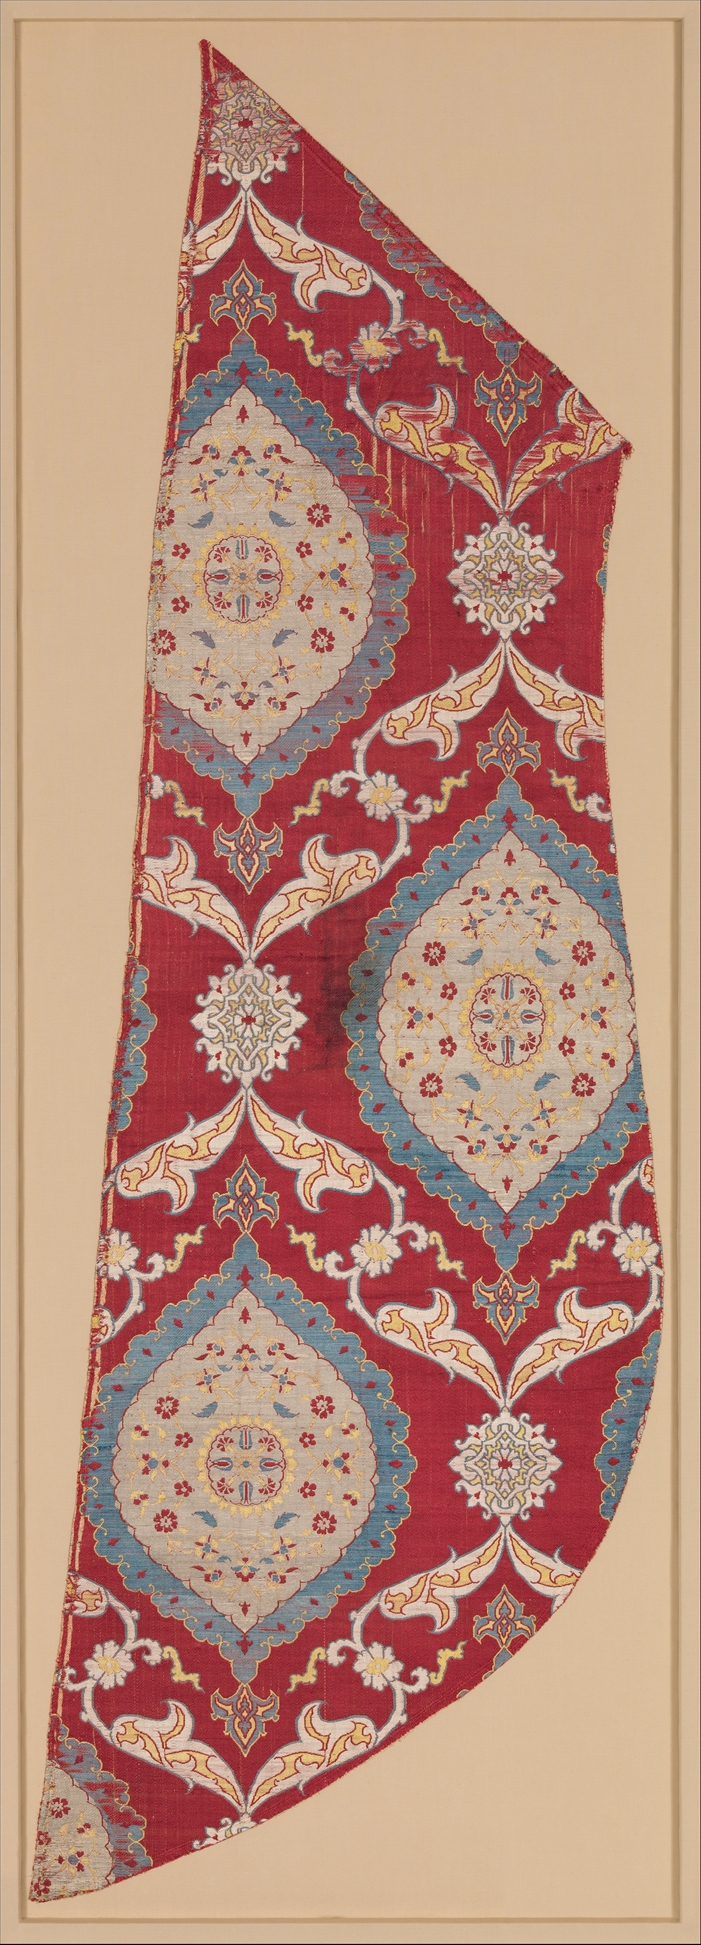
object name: textile fragment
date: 1501-1600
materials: metal thread, silk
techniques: lampas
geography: turkey